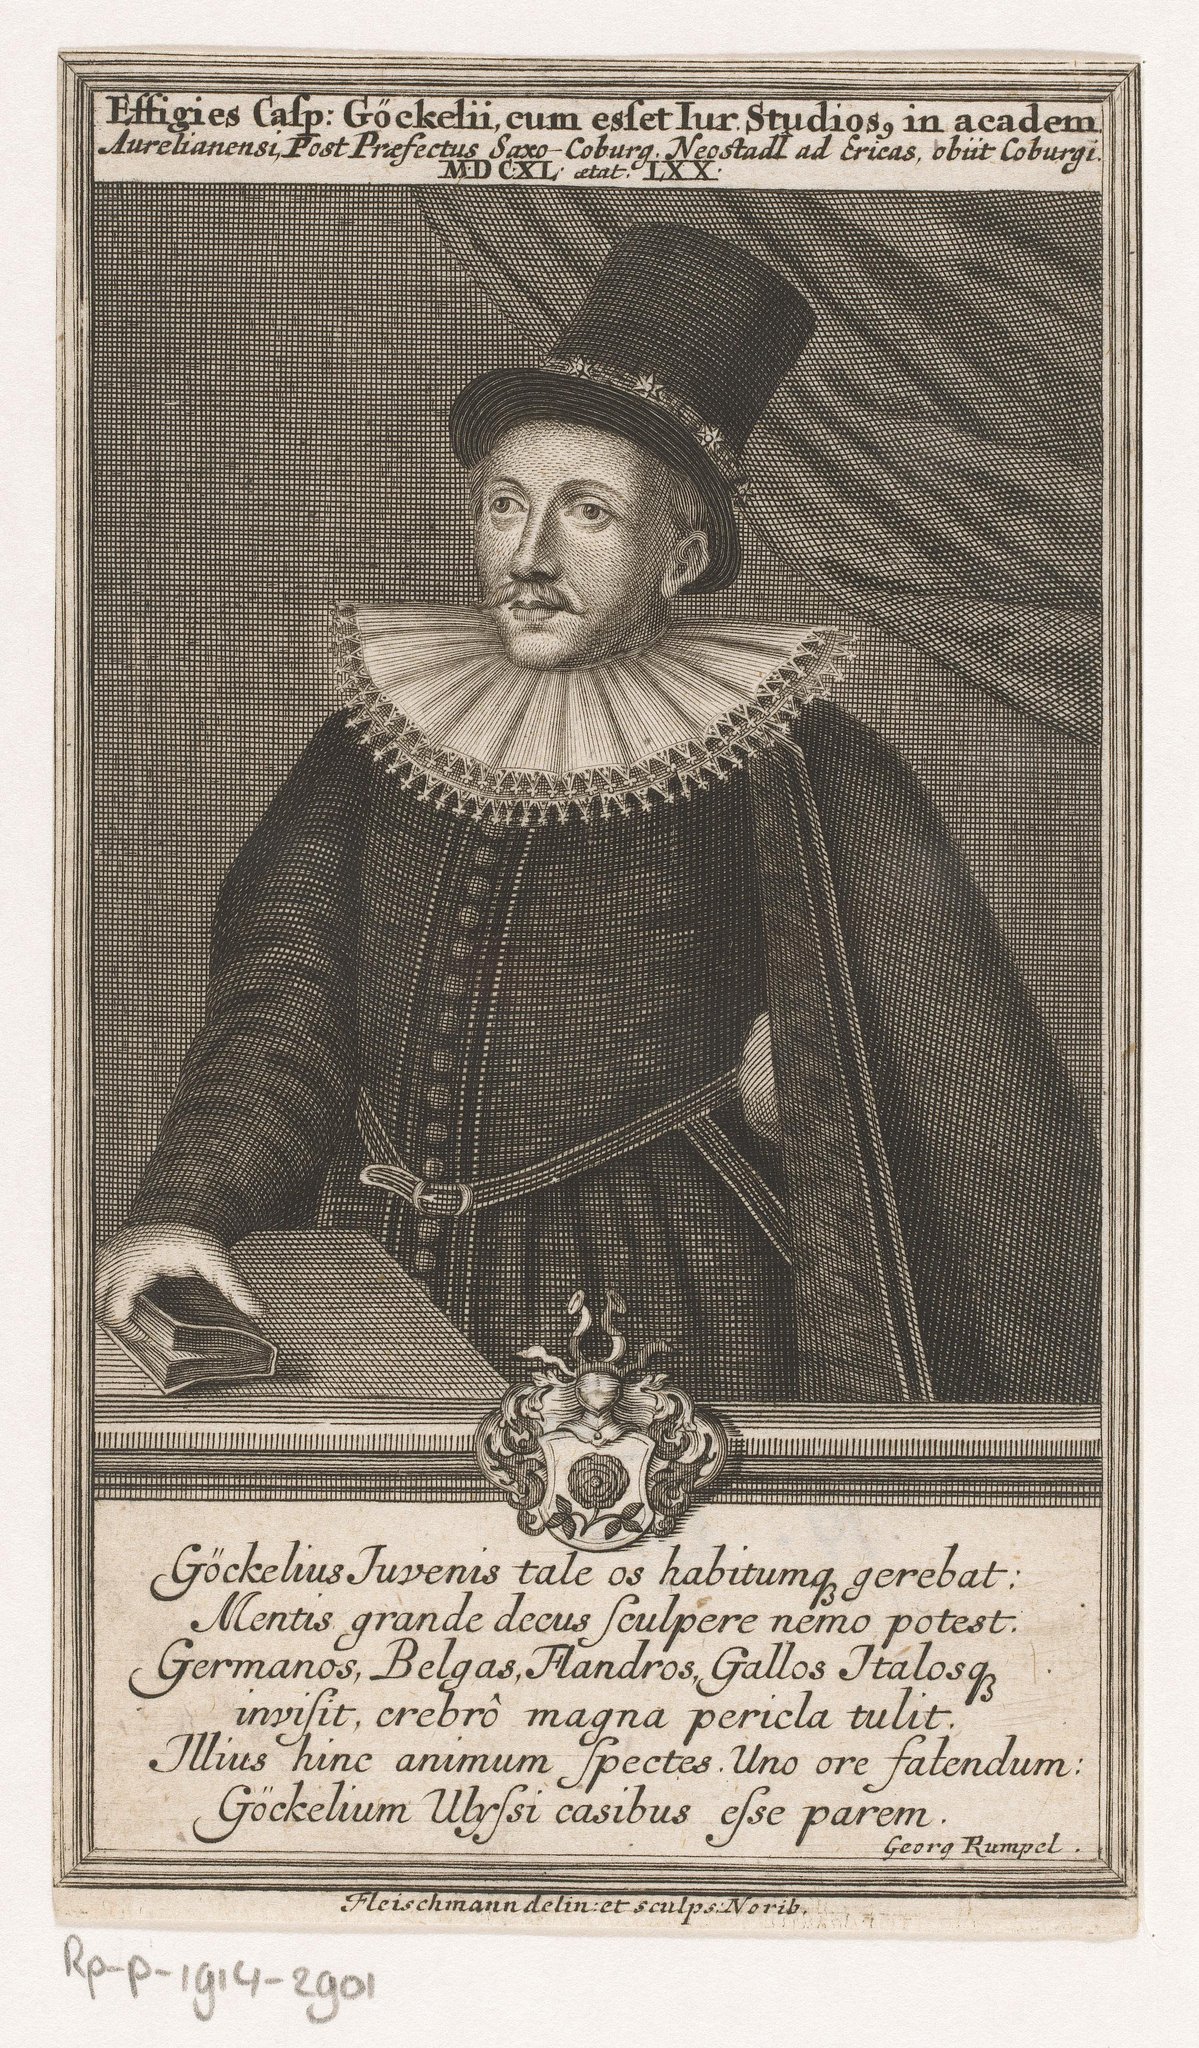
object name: print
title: Portret van Caspar Göckel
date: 1704-1732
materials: paper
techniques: engraving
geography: nuremberg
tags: historical persons, book, armorial bearing, heraldry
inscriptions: collector's mark: Lugt 2228